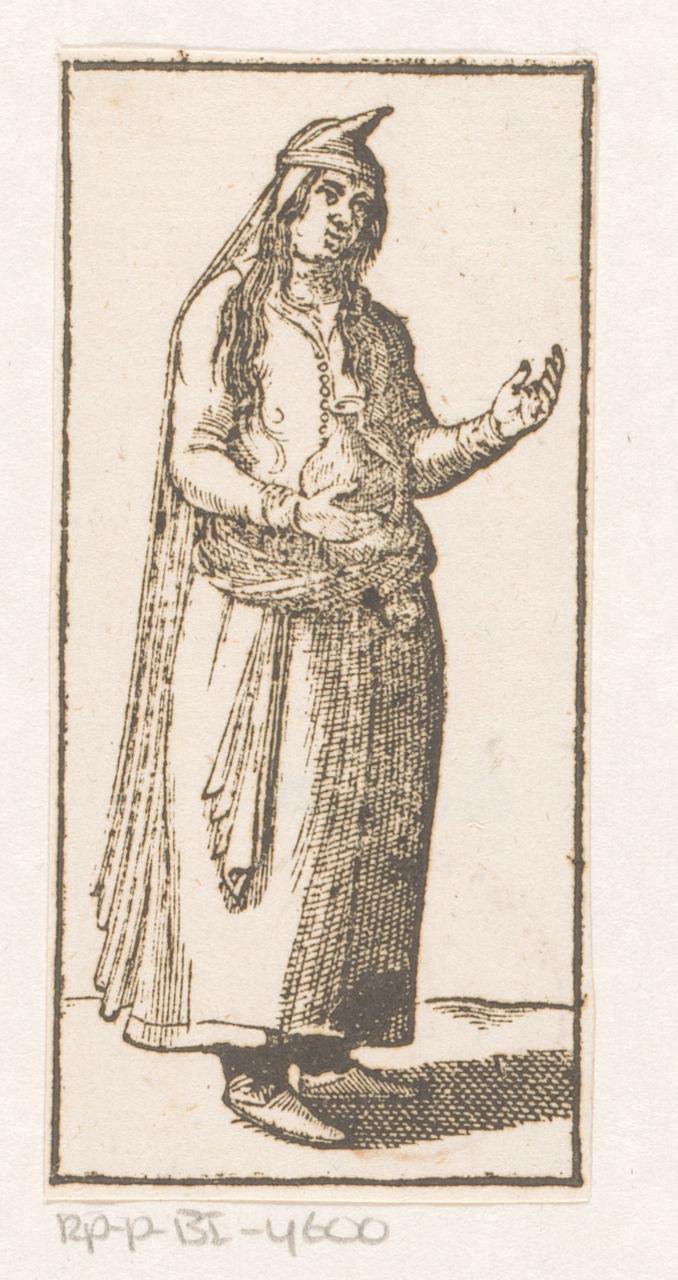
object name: print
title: Staande figuur met een muts en een kruik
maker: Anonymous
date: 1600-1699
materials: paper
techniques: woodcut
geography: netherlands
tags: standing figure, head-gear, container of ceramics: jar, jug, pot, vase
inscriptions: collector's mark: Lugt 240